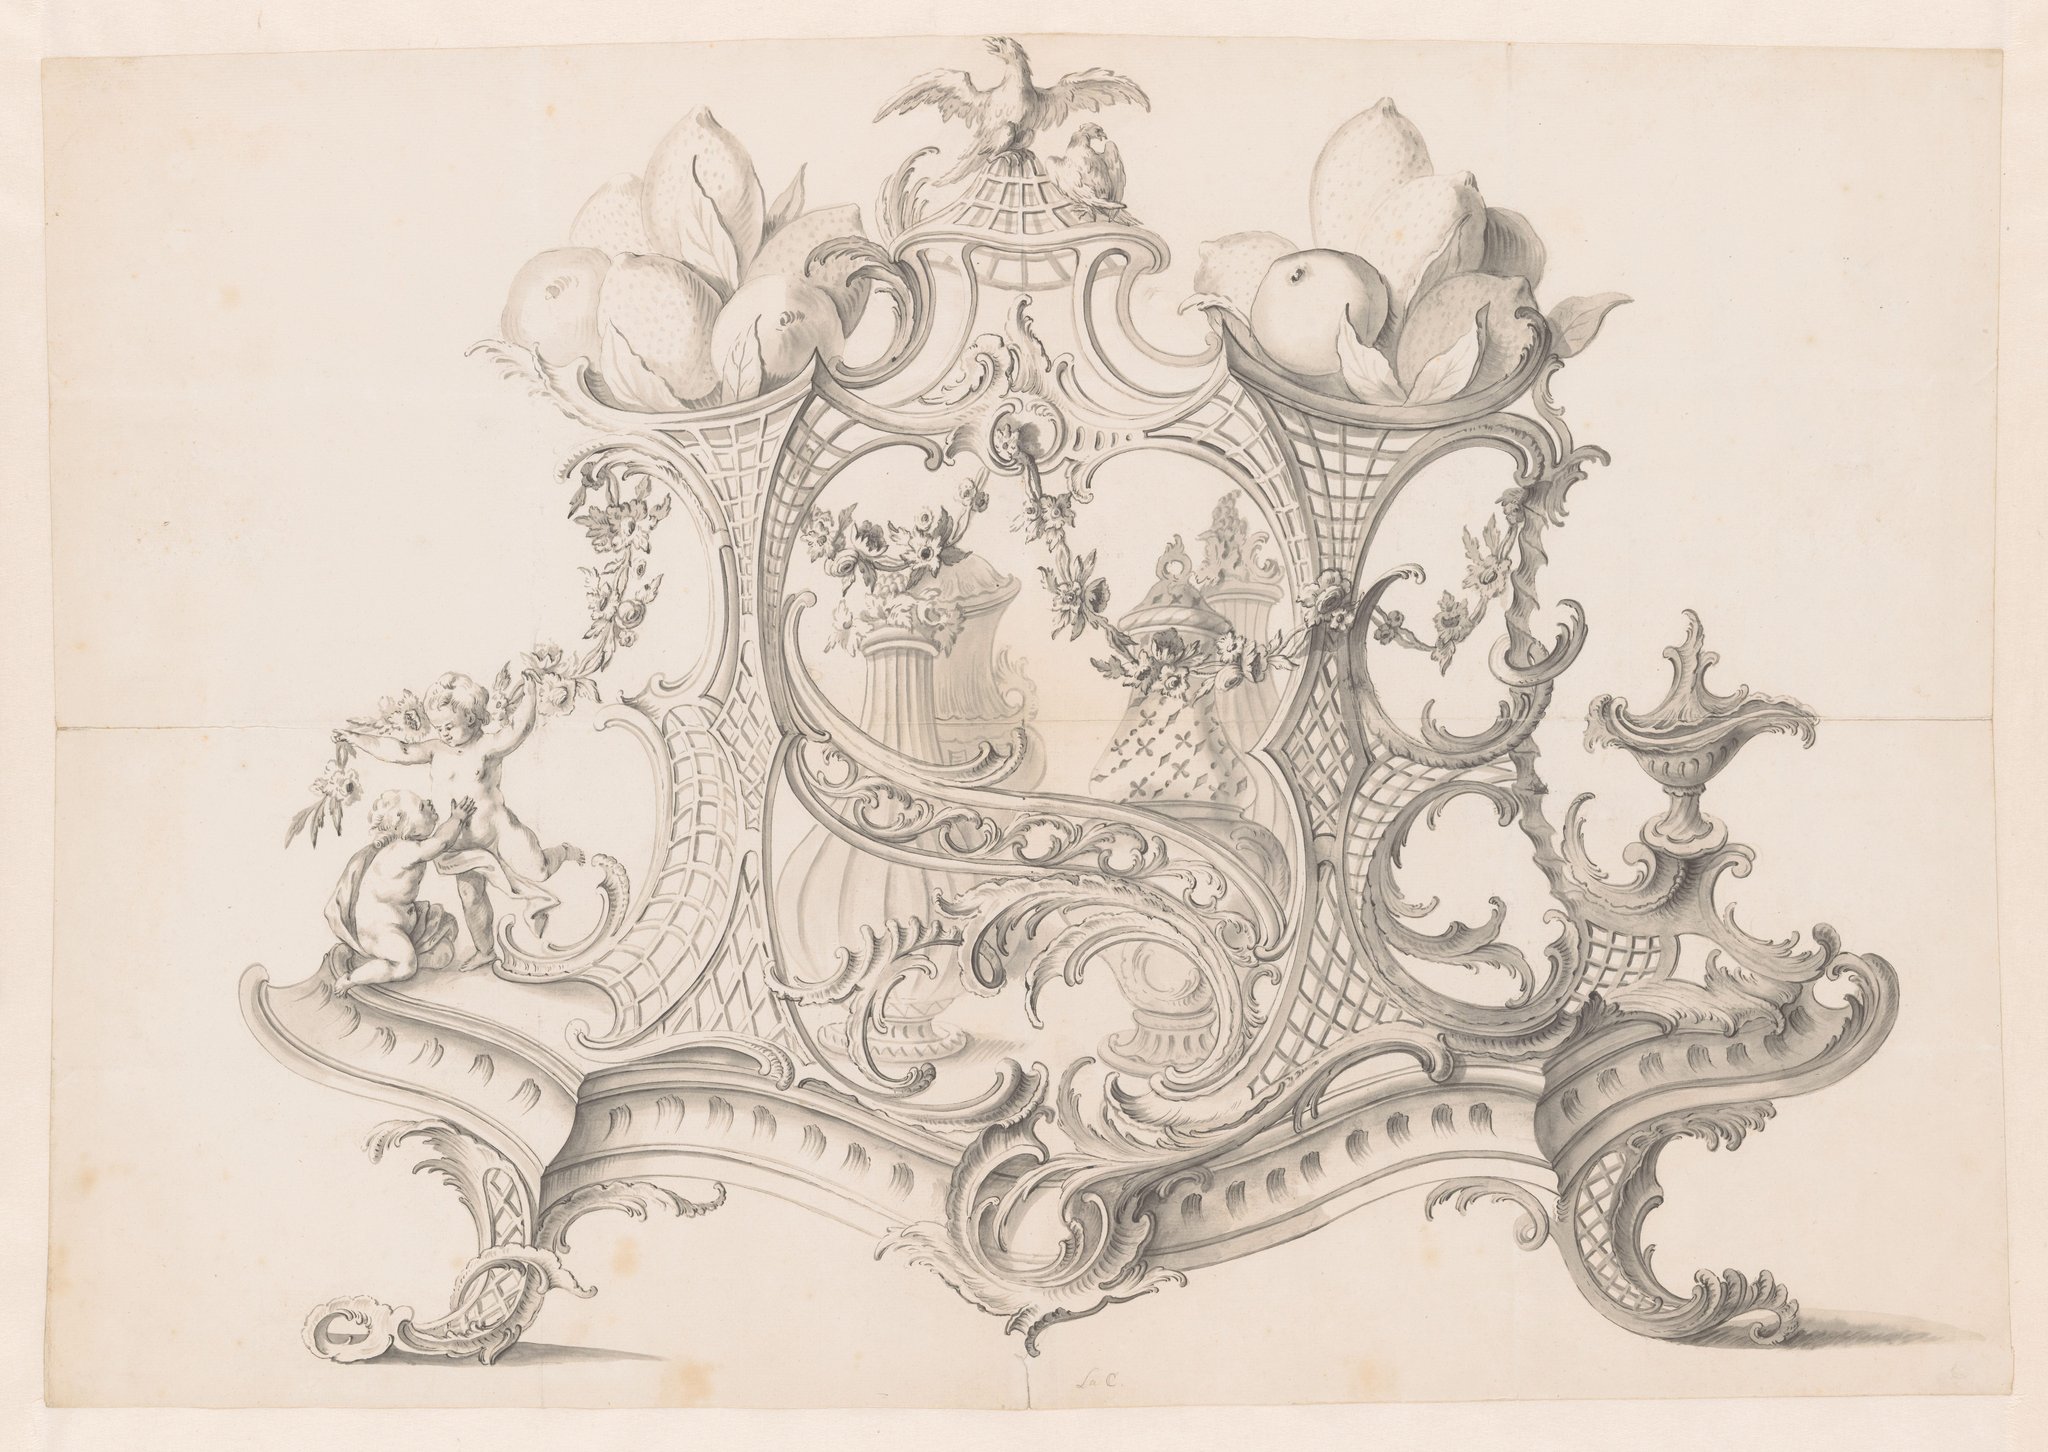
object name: design drawing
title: Tafelstuk met twee jongetjes met bloemslingers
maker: Anonymous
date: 1760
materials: graphite, ink, paper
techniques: brush, pen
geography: augsburg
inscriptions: watermark, inscription: ‘La C.’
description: De jongens worden bekroond door twee adelaars, met vier losse bussen en twee houders gevuld met citroenen.